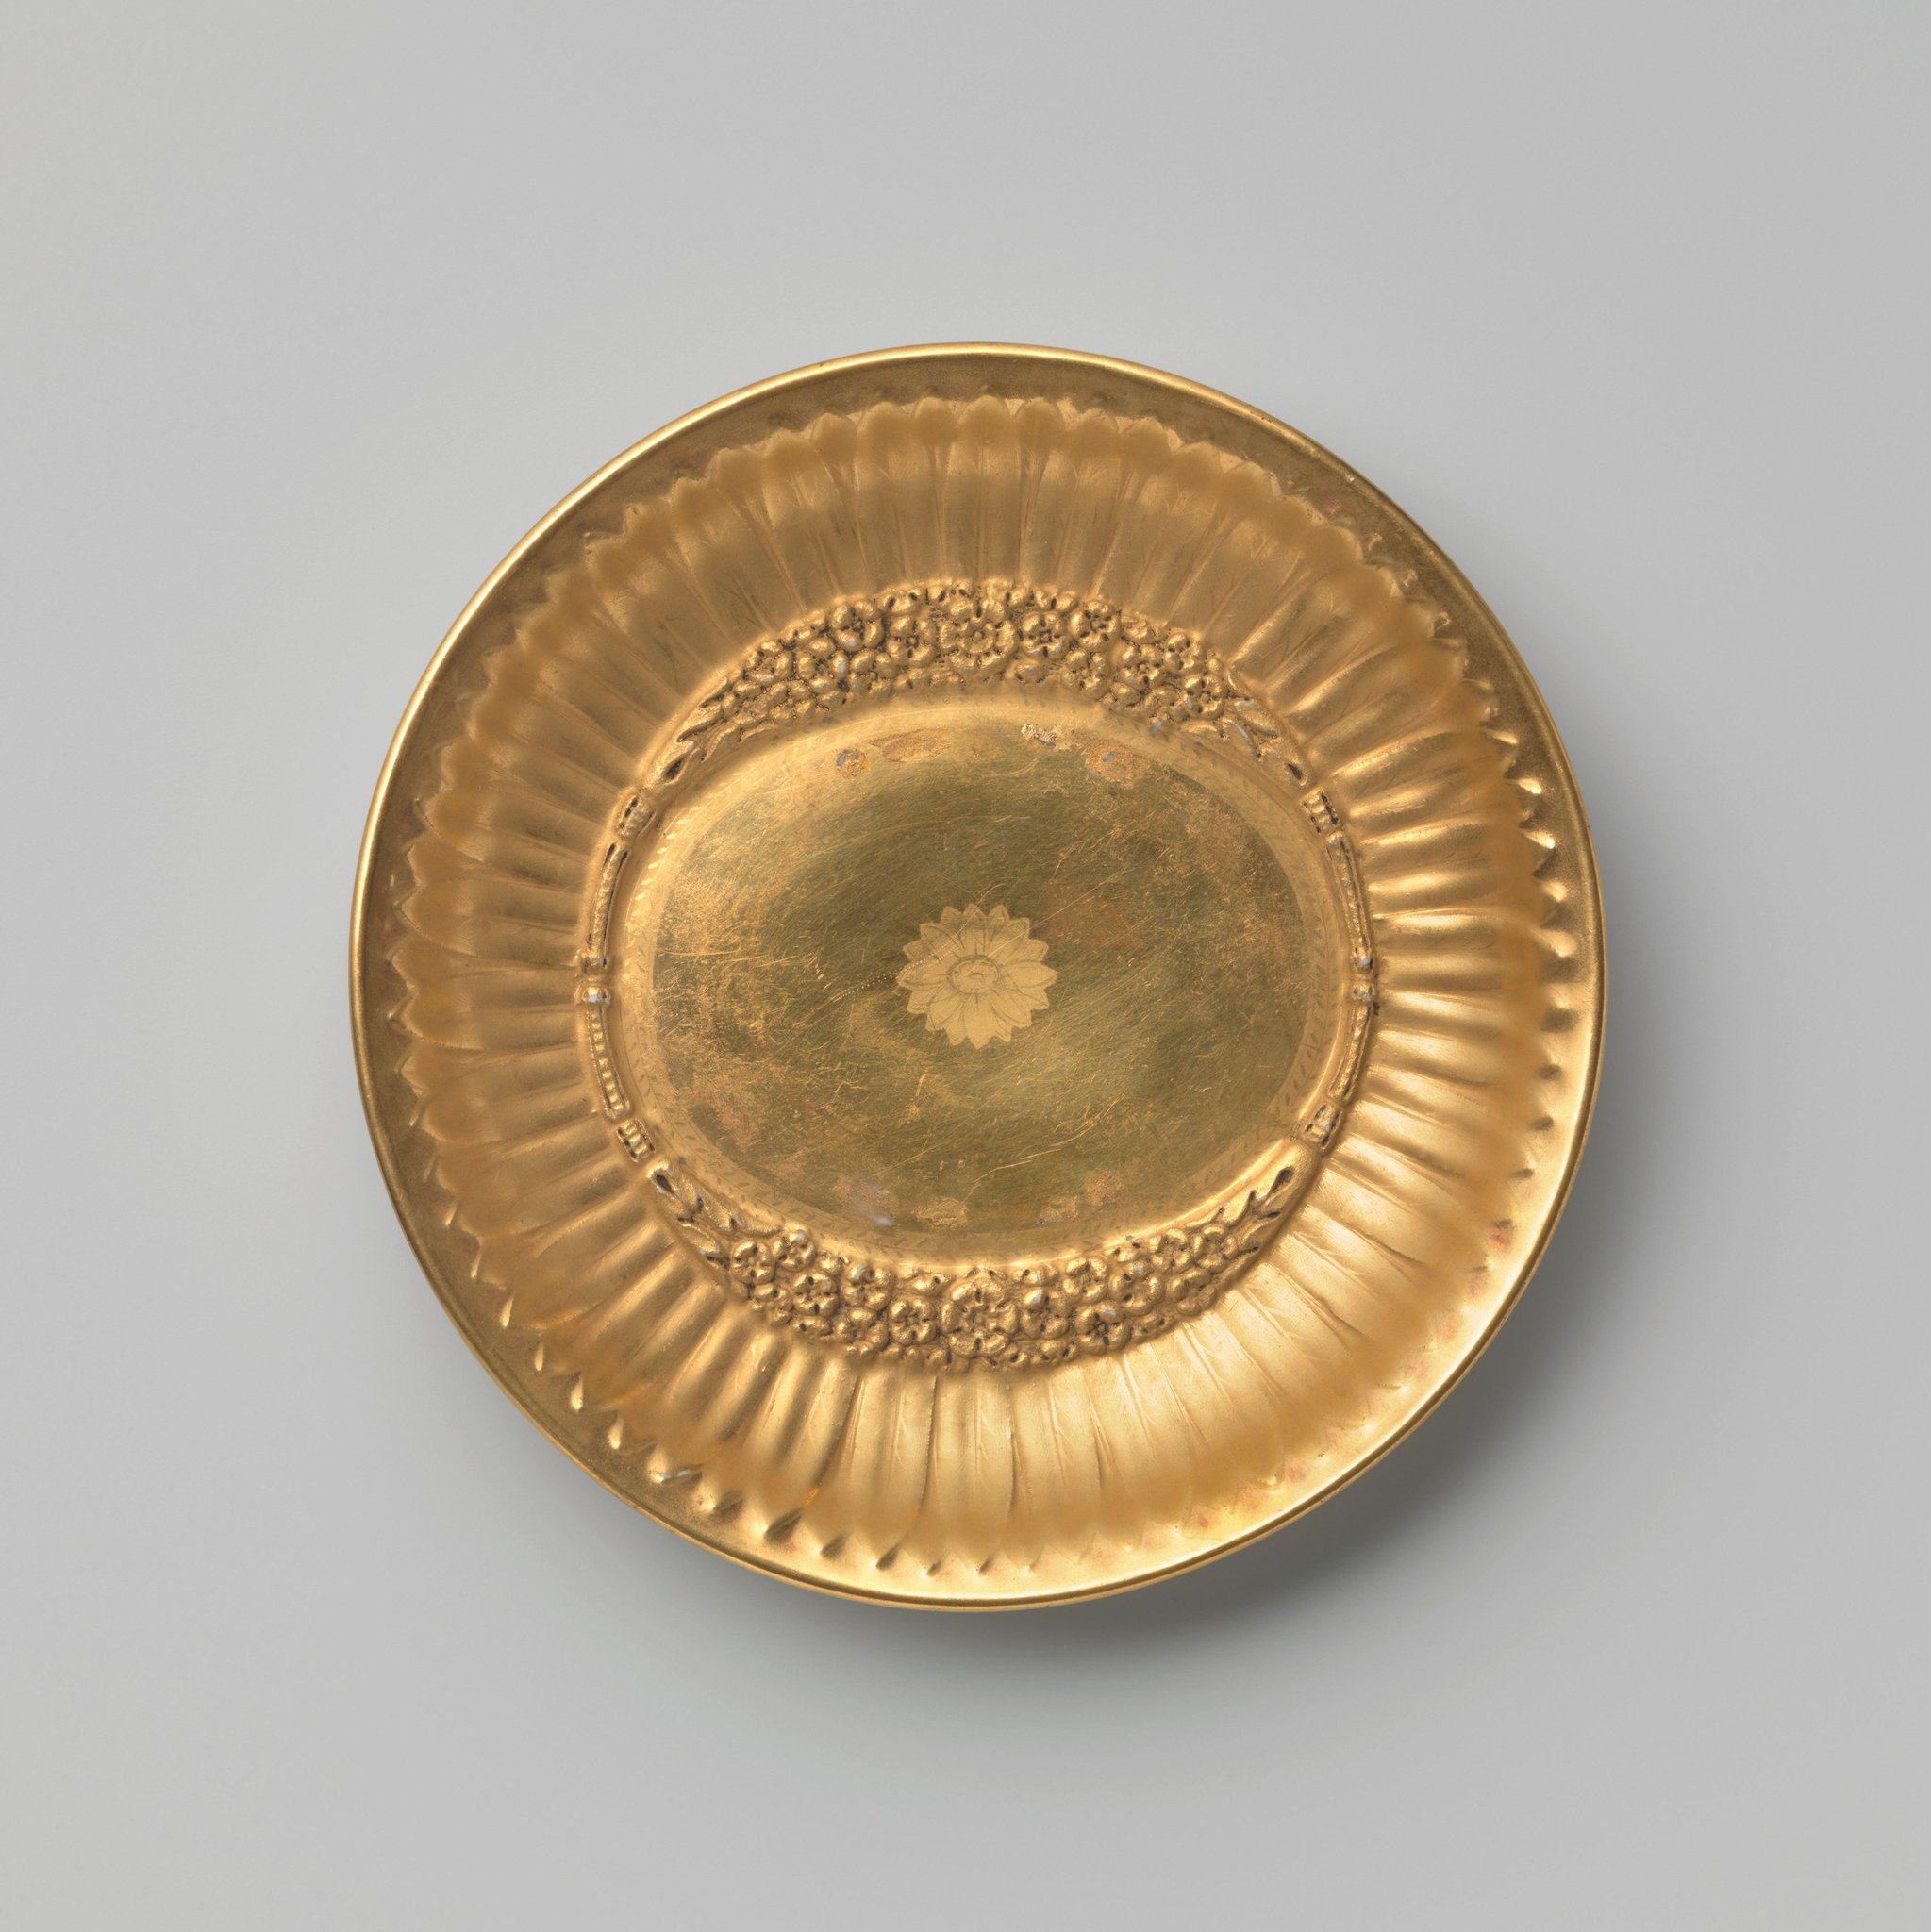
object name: platter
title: Saucer with petals, a roundel and garlands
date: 1800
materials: glaze, gold, paint, porcelain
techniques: firing, forming, gilding, relief, vitrification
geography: limoges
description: Schotel van porselein, bedekt met goud. Op het plat een ingegrift rozet, omgeven door gemodelleerde guirlandes. Hieromheen, op de wand, een band van bloembladeren in reliëf. De buitenwand met een gouden lijn op de voet en de rand.